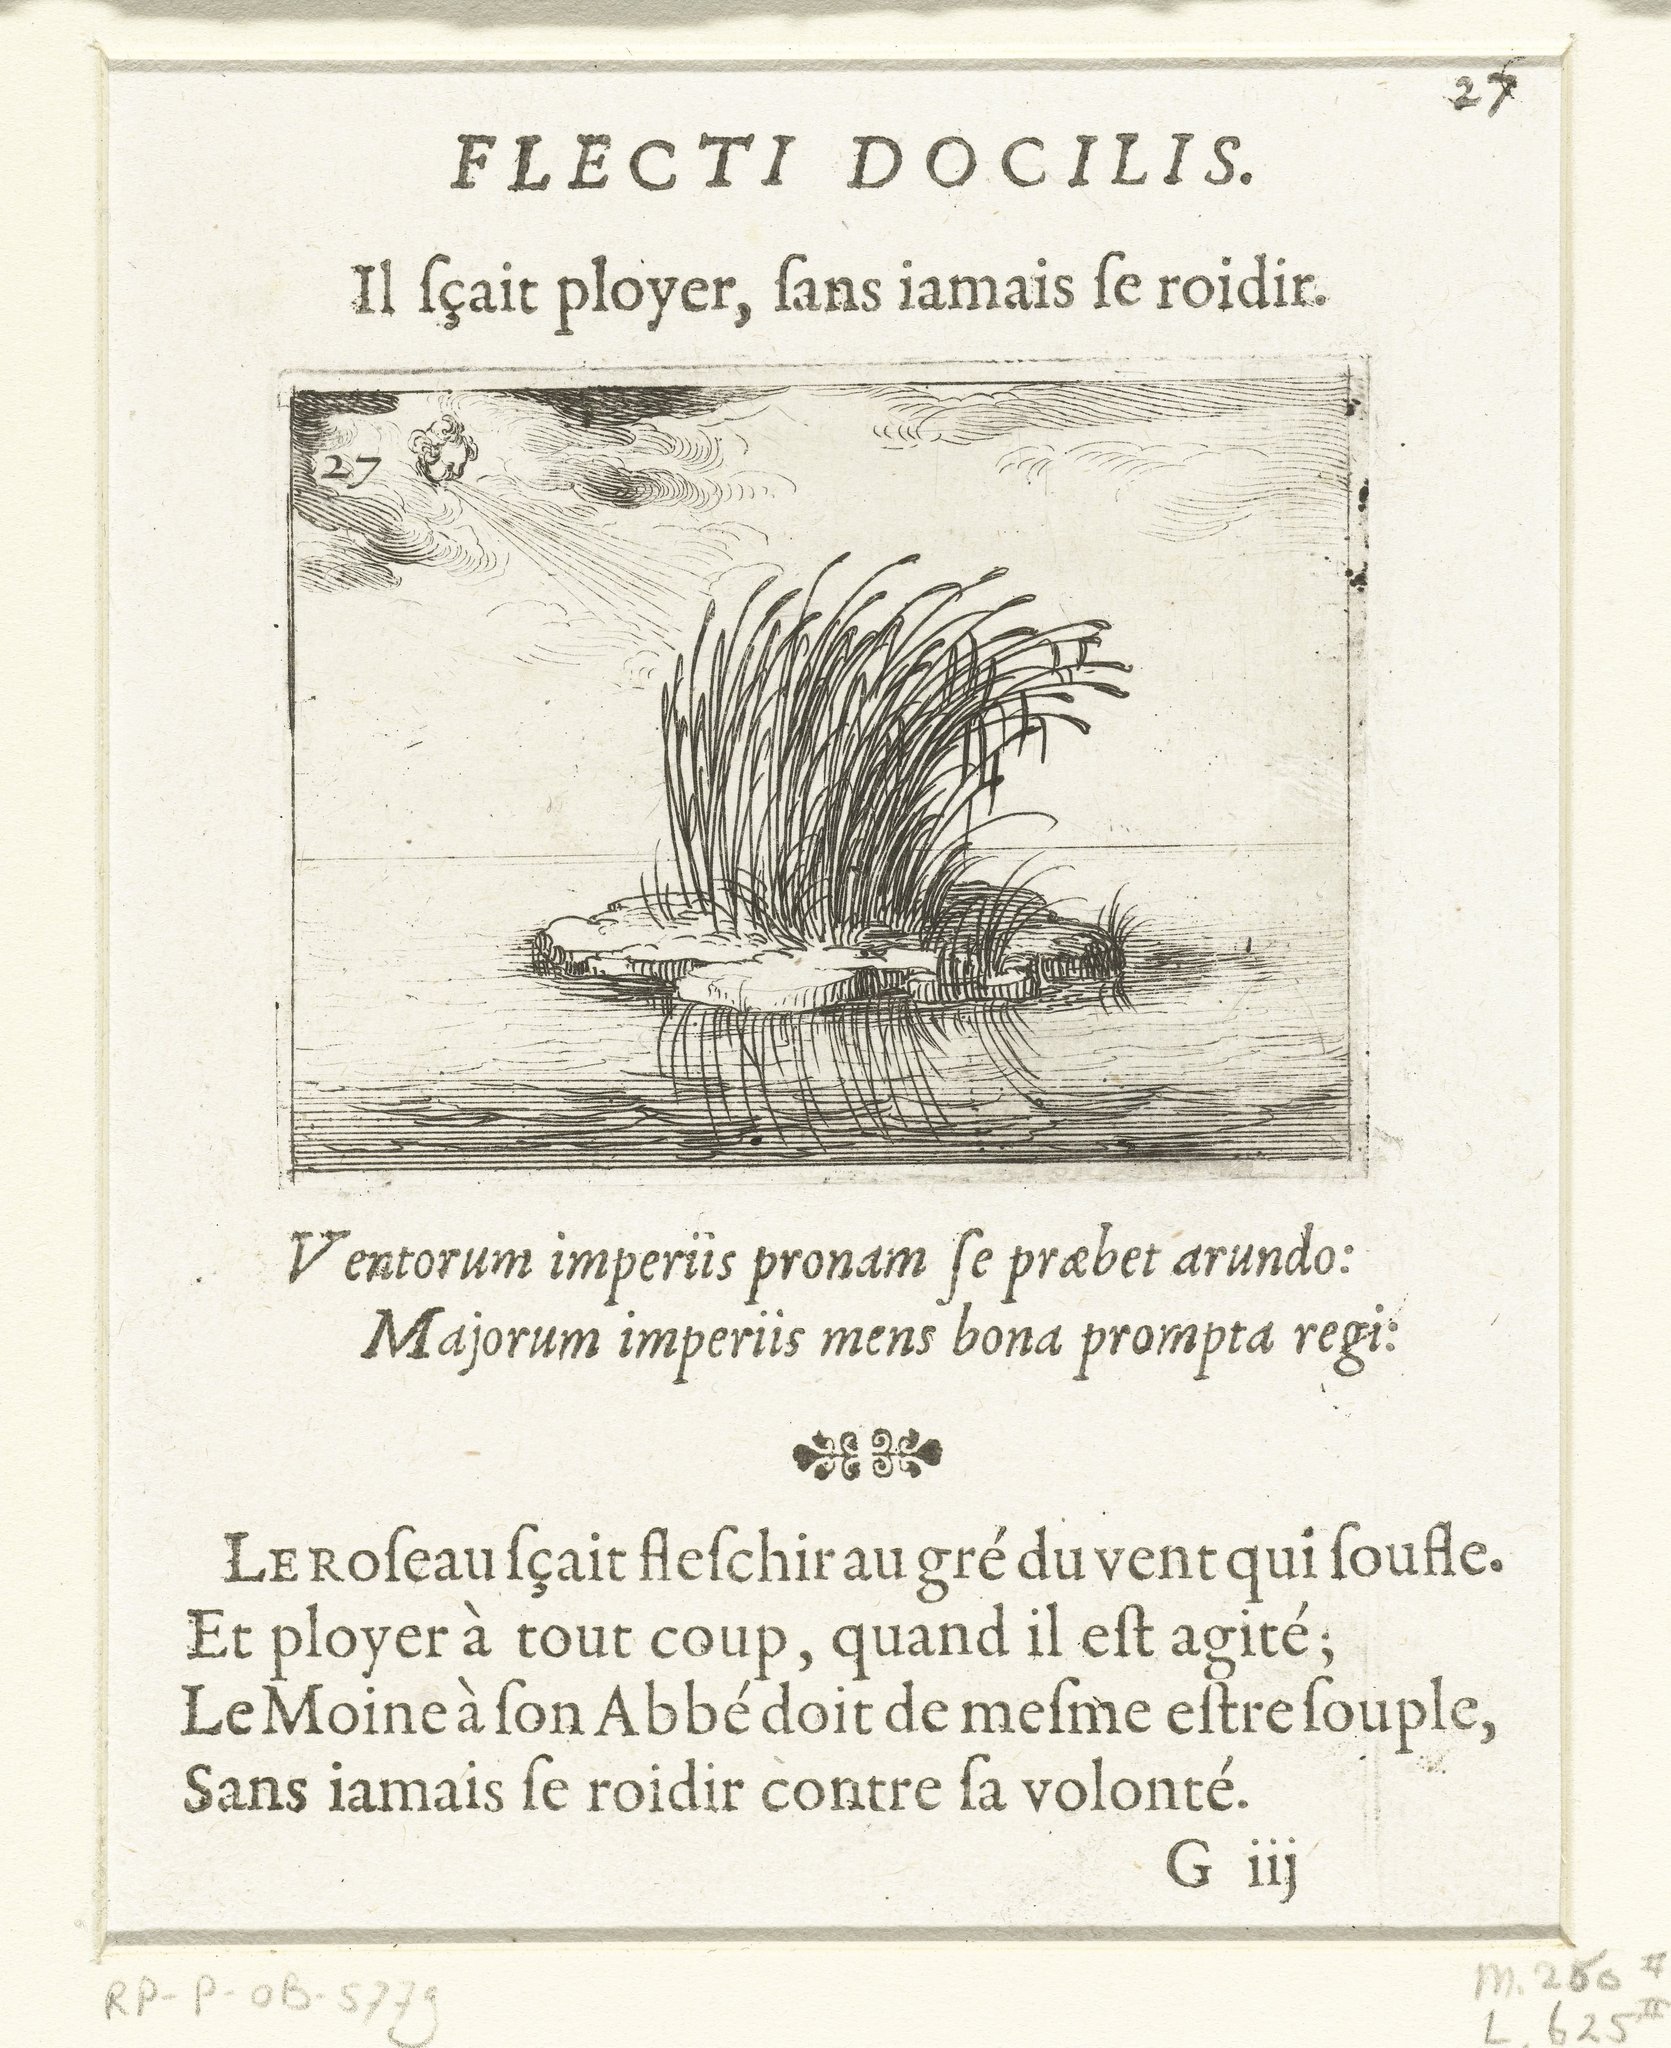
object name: cognizance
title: Kloosterleven in emblemen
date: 1621-1635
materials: paper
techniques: etching, letterpress printing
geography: nancy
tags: winds, plants and herbs: reed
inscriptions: collector's mark: Lugt 240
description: Voorstelling van rietstengels, wuivend in de wind, op een klein eilandje in het water. Boven en onder deze prent Latijnse en Franse teksten in boekdruk. Dit blad is onderdeel van de embleemserie 'Kloosterleven in emblemen'. De tweede staat van deze serie behelst naast een geïllustreerde titelpagina en 26 emblemen nog een titelpagina en een blad met opdracht, beide in boekdruk zonder afbeelding.